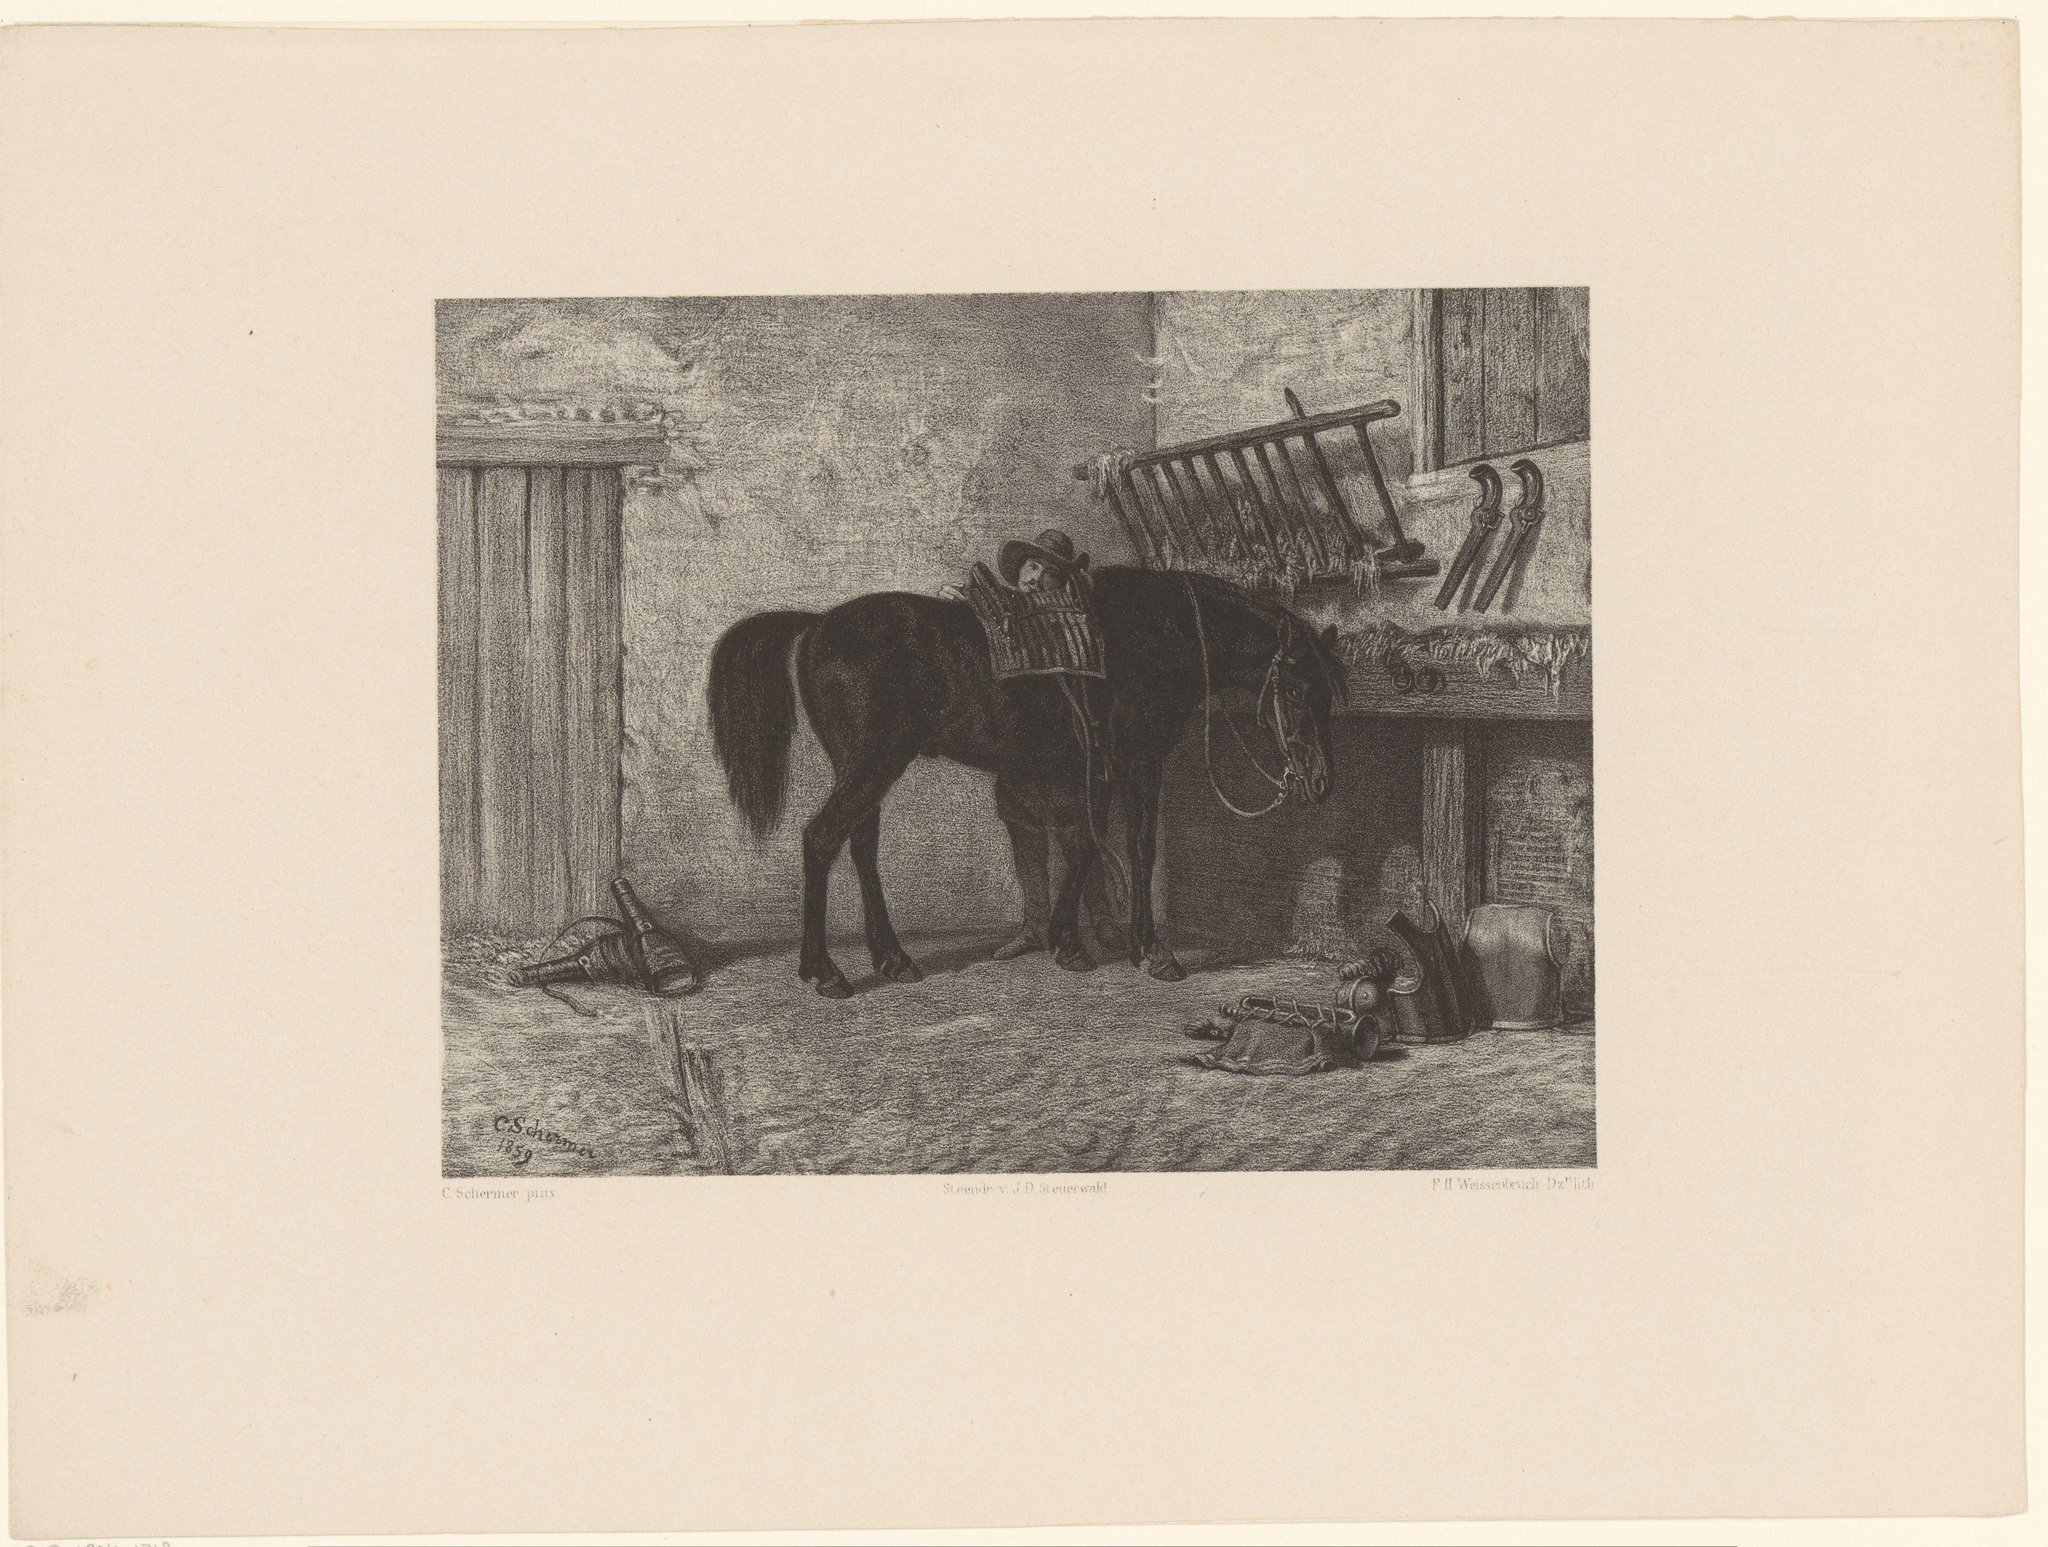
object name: print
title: Man zadelt paard op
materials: paper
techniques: lithograph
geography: the hague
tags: barn, saddling and bridling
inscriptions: collector's mark: Lugt 2228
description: In een stal zadelt aan man zijn paard op. Rechts hangen twee pistolen, op de grond liggen zijn trompet en harnas.